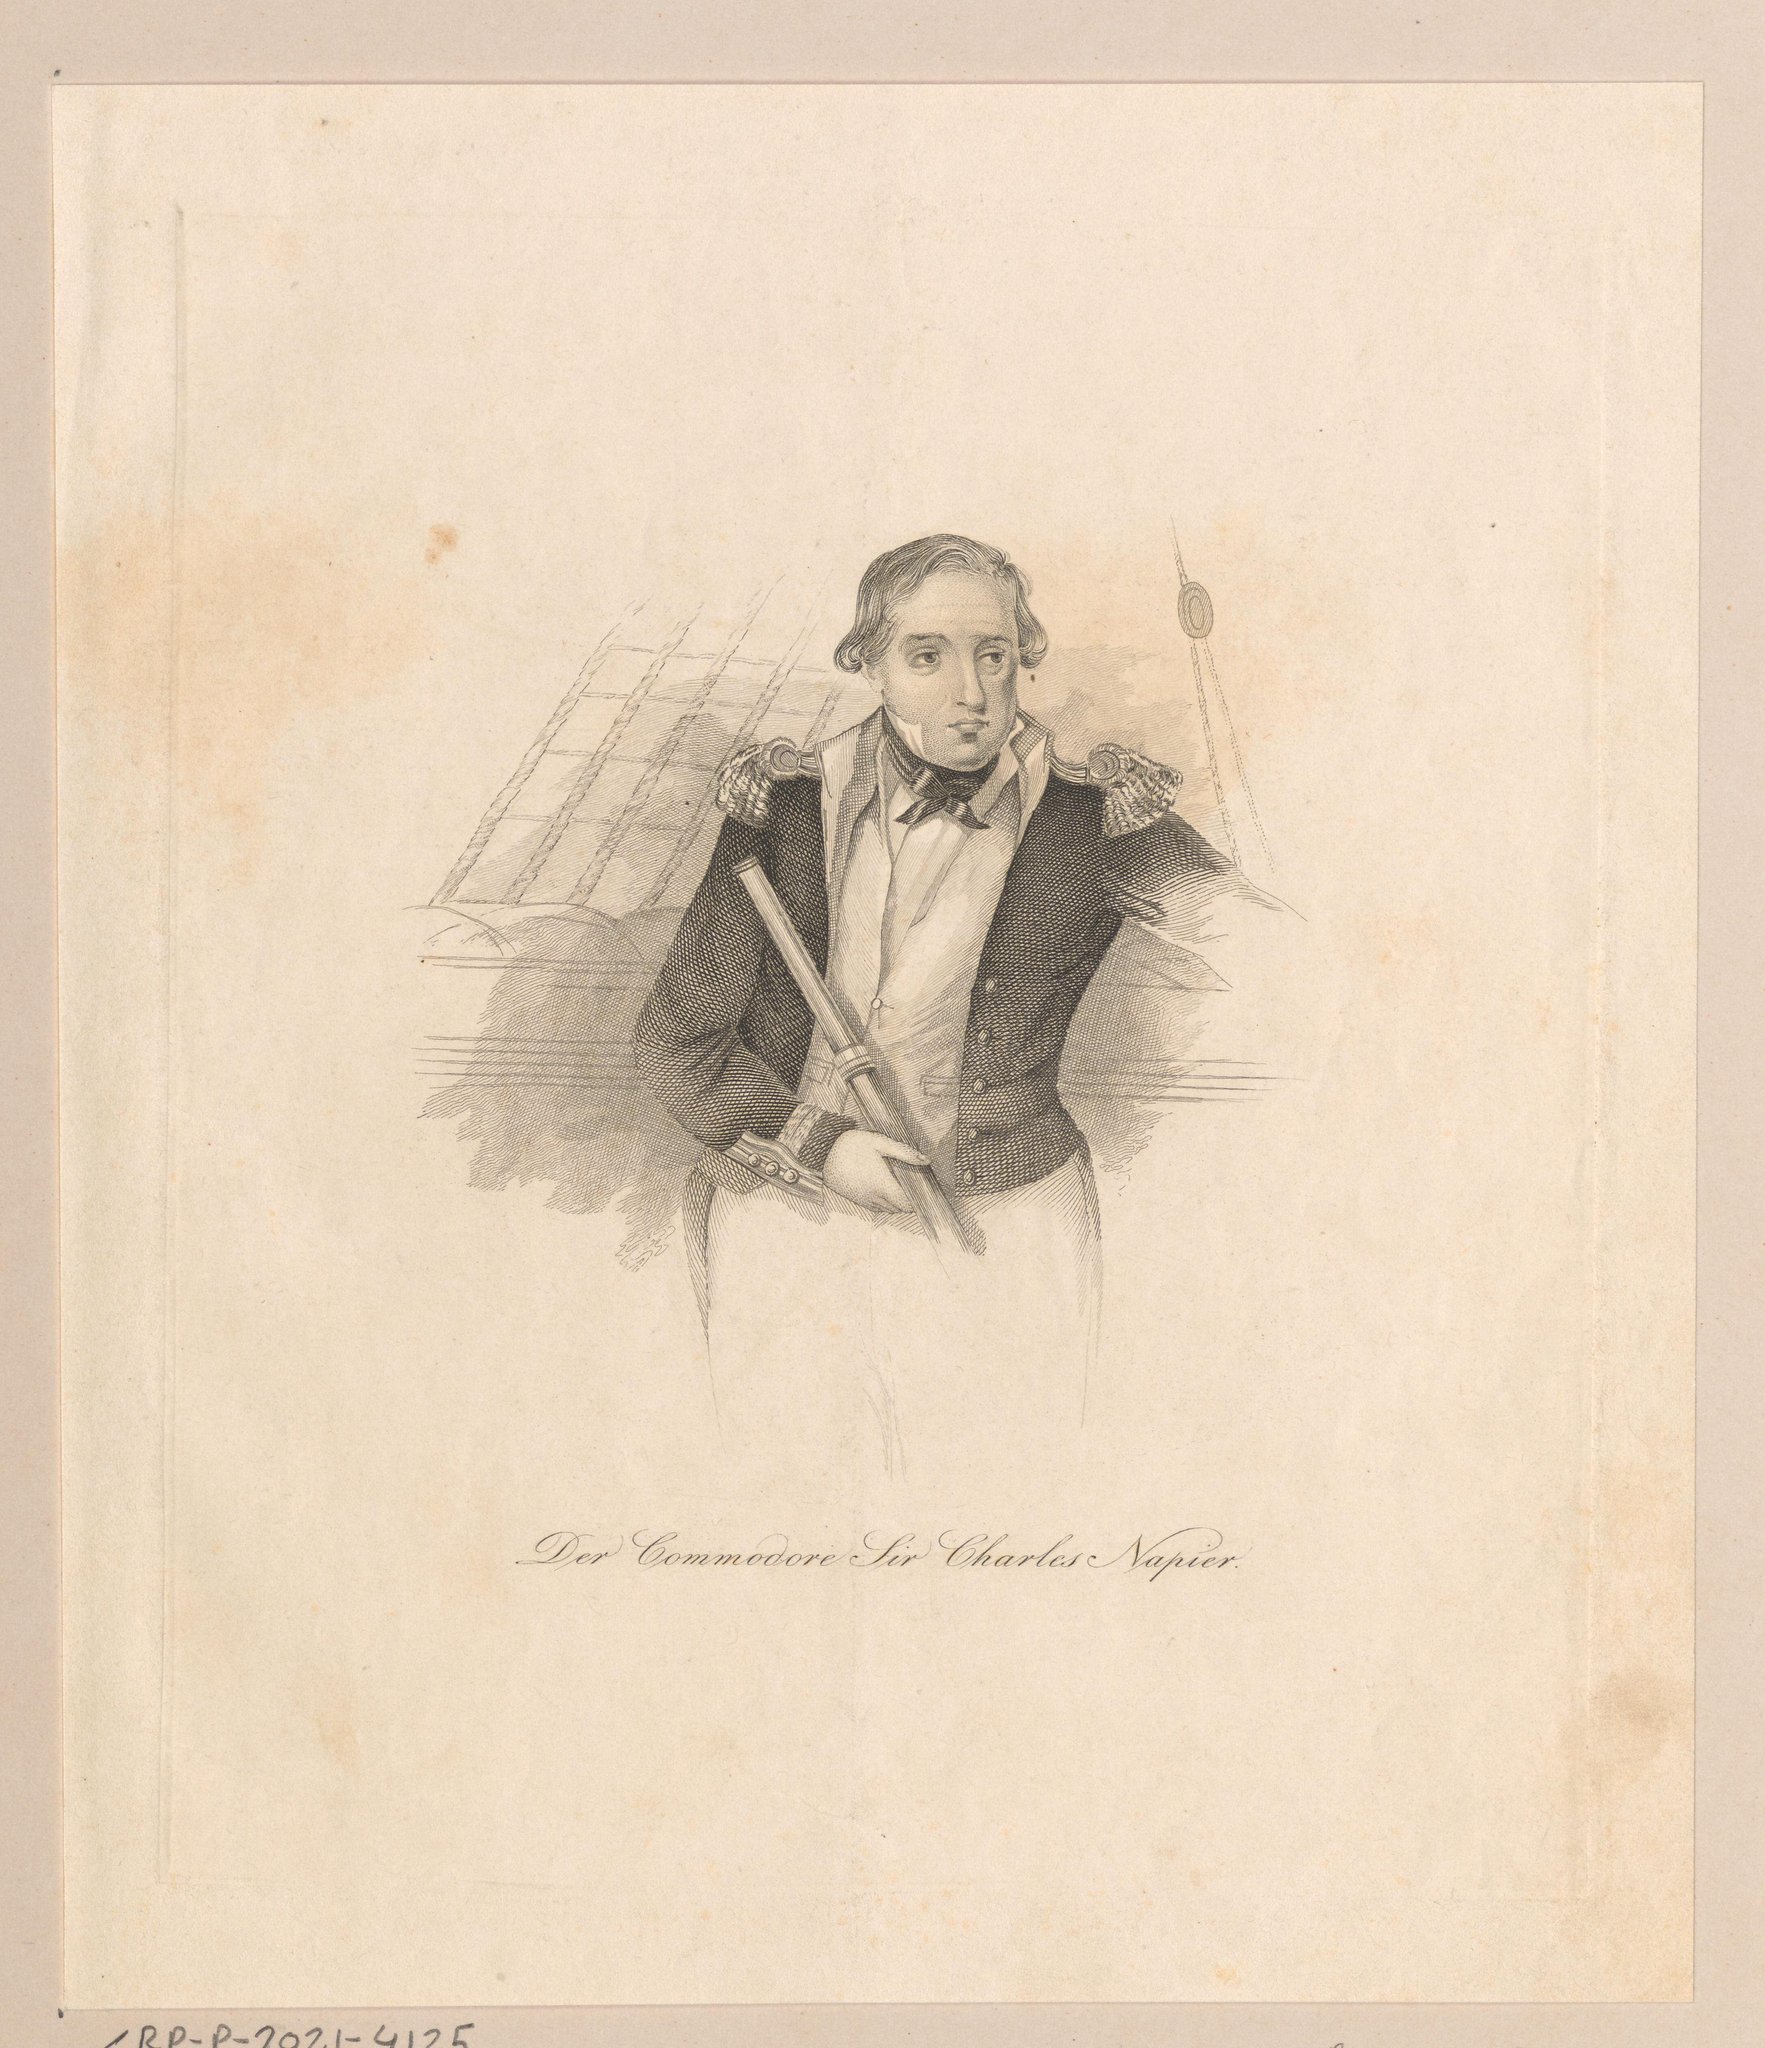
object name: print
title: Portret van Charles John Napier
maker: Anonymous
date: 1840-1860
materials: paper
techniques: etching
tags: naval officer, historical persons, commander-in-chief, admiral